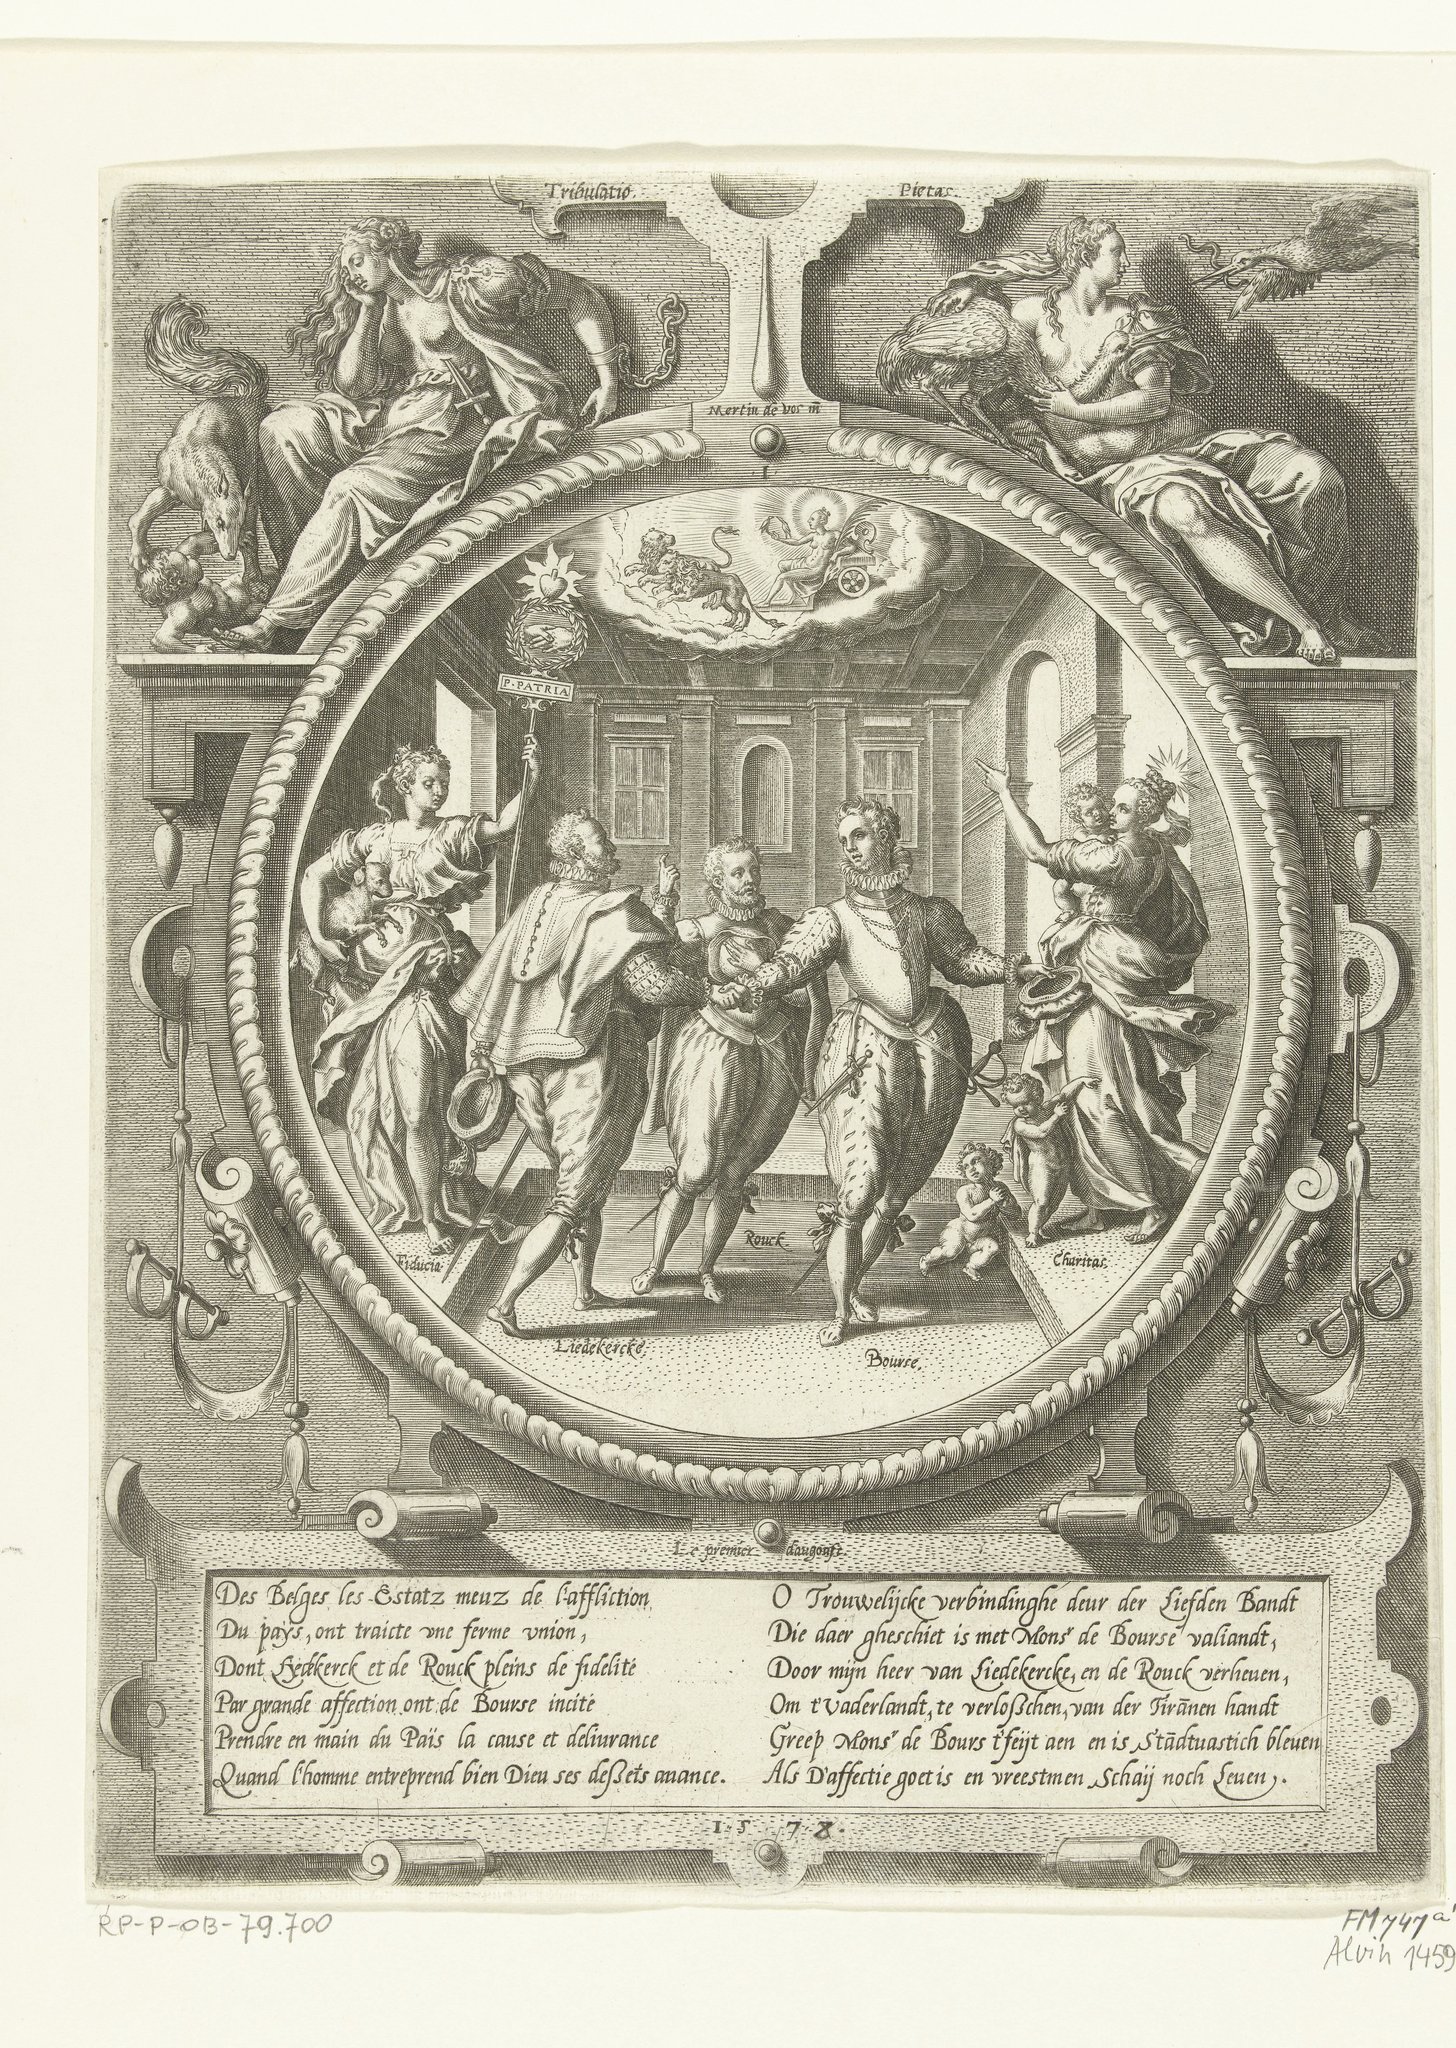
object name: print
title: Medaillons met de verovering van de citadel van Antwerpen in 1577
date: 1578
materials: paper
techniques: engraving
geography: southern netherlands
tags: charity, 'caritas'; 'carità' (ripa) ~ one of the three theological virtues, torment; 'tribulatione' (ripa), fidelity; 'fedeltà' (ripa), triumph of venus; 'carro di venere' (ripa), piety, 'pietas', 'timor dei' ~ the three theological virtues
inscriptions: date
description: Het verbond tussen Liedekercke, Roeck en Bourse, om de Citadel van Antwerpen te veroveren, 1 augustus 1577. Interieur waarin de drie mannen een eed afleggen. Links Trouw (Fiducia) en Liefde (Charitas), in de wolken de triomfwagen van Venus. Voorstelling in een rond medaillon met ornamentele allegorische omlijsting met bovenaan de zittende vrouwelijke personificaties van Kwelling (Tribulatio) en Vroomheid (Pietas). Onderaan een cartouche met 2 verzen van elk 6 regels in het Frans en Nederlands.